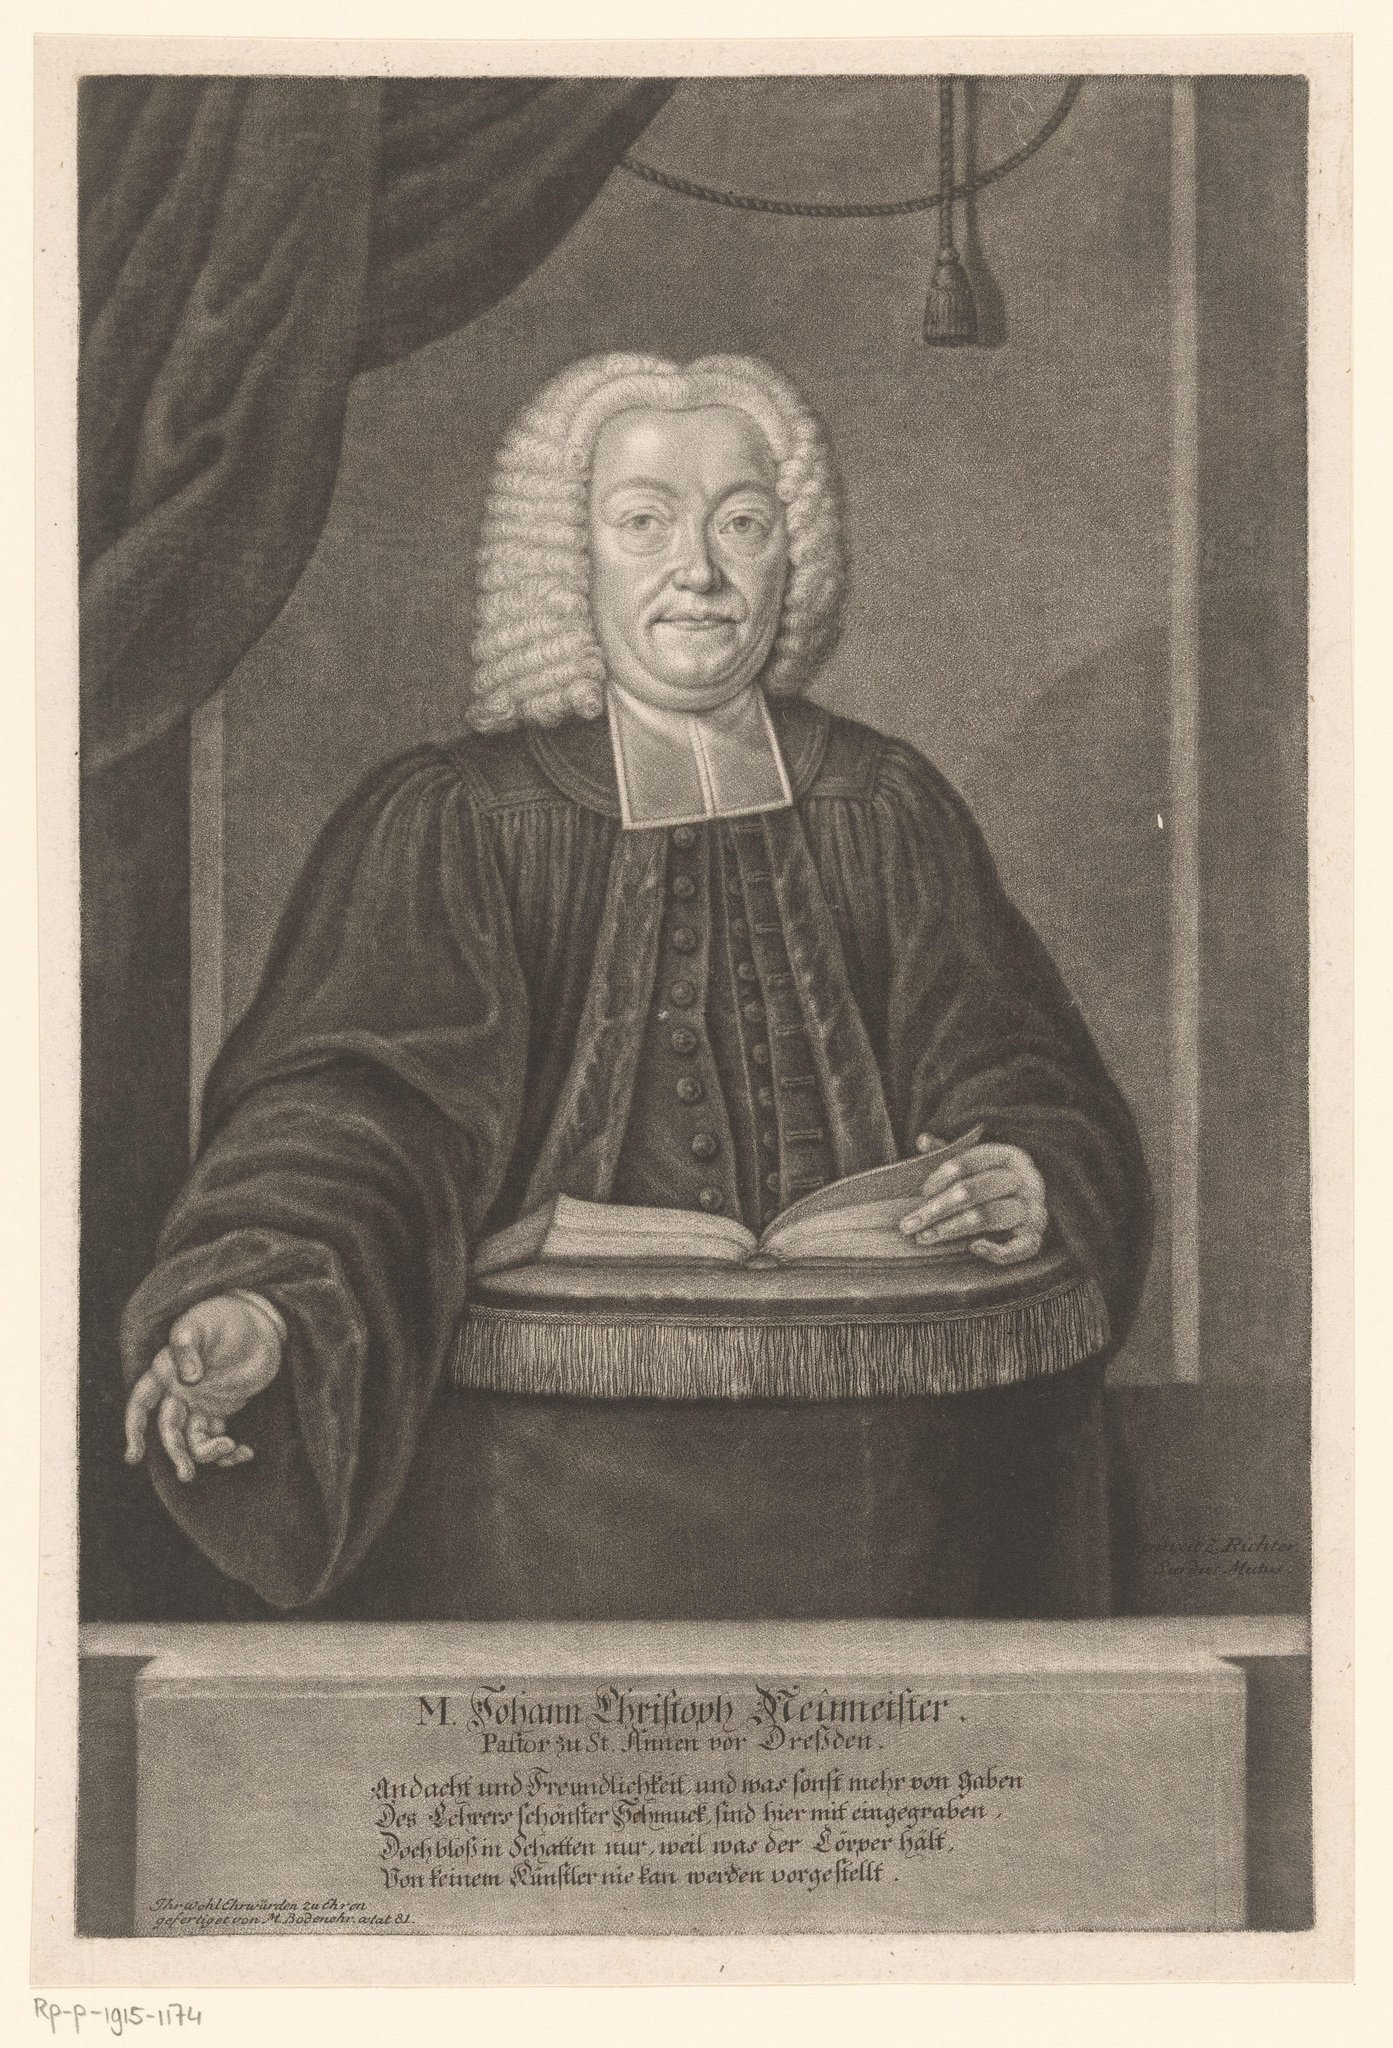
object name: print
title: Portret van Johann Christoph Neumeister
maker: moritz bodenehr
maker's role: print maker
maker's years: 1665-1749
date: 1746-1748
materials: paper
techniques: mezzotint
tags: theologian, historical persons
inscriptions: collector's mark: Lugt 2228